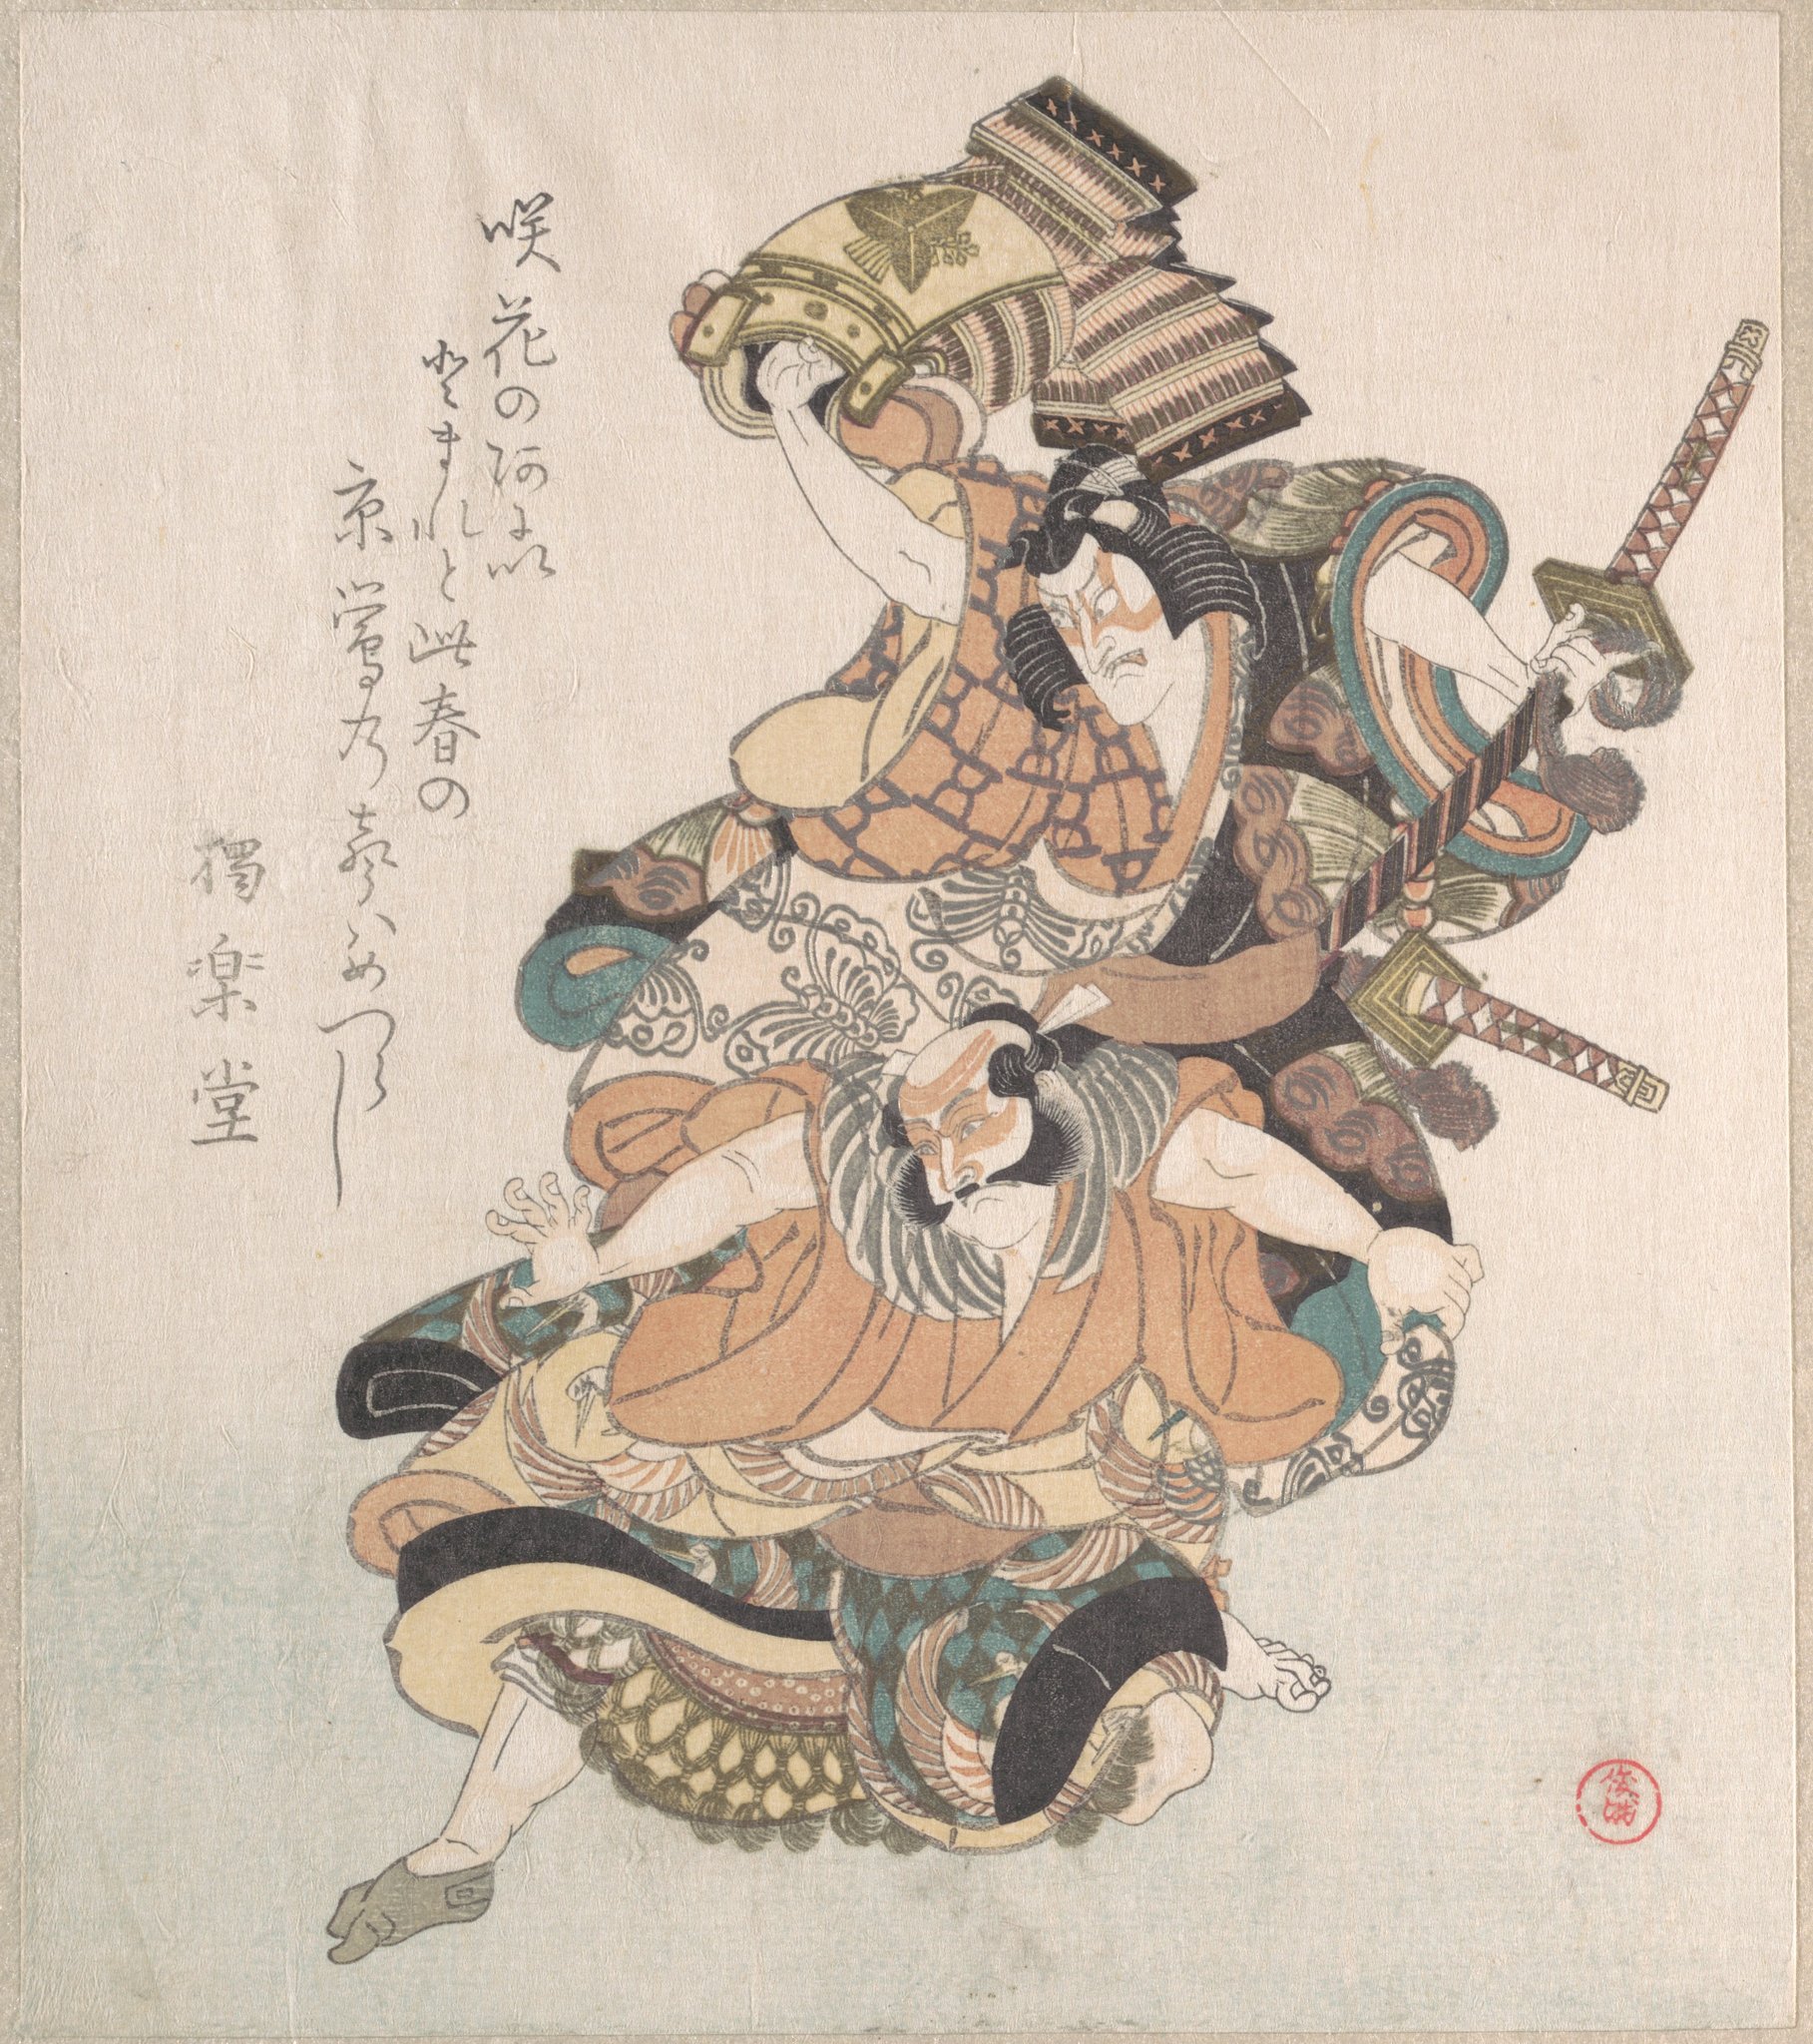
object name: print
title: Two Actors; a Scene from the Soga Play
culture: japanese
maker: kubo shunman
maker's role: artist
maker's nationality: japanese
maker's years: 1757-1820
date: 1801-1900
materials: ink, paper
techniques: surimono, woodblock print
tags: swords,men,actors